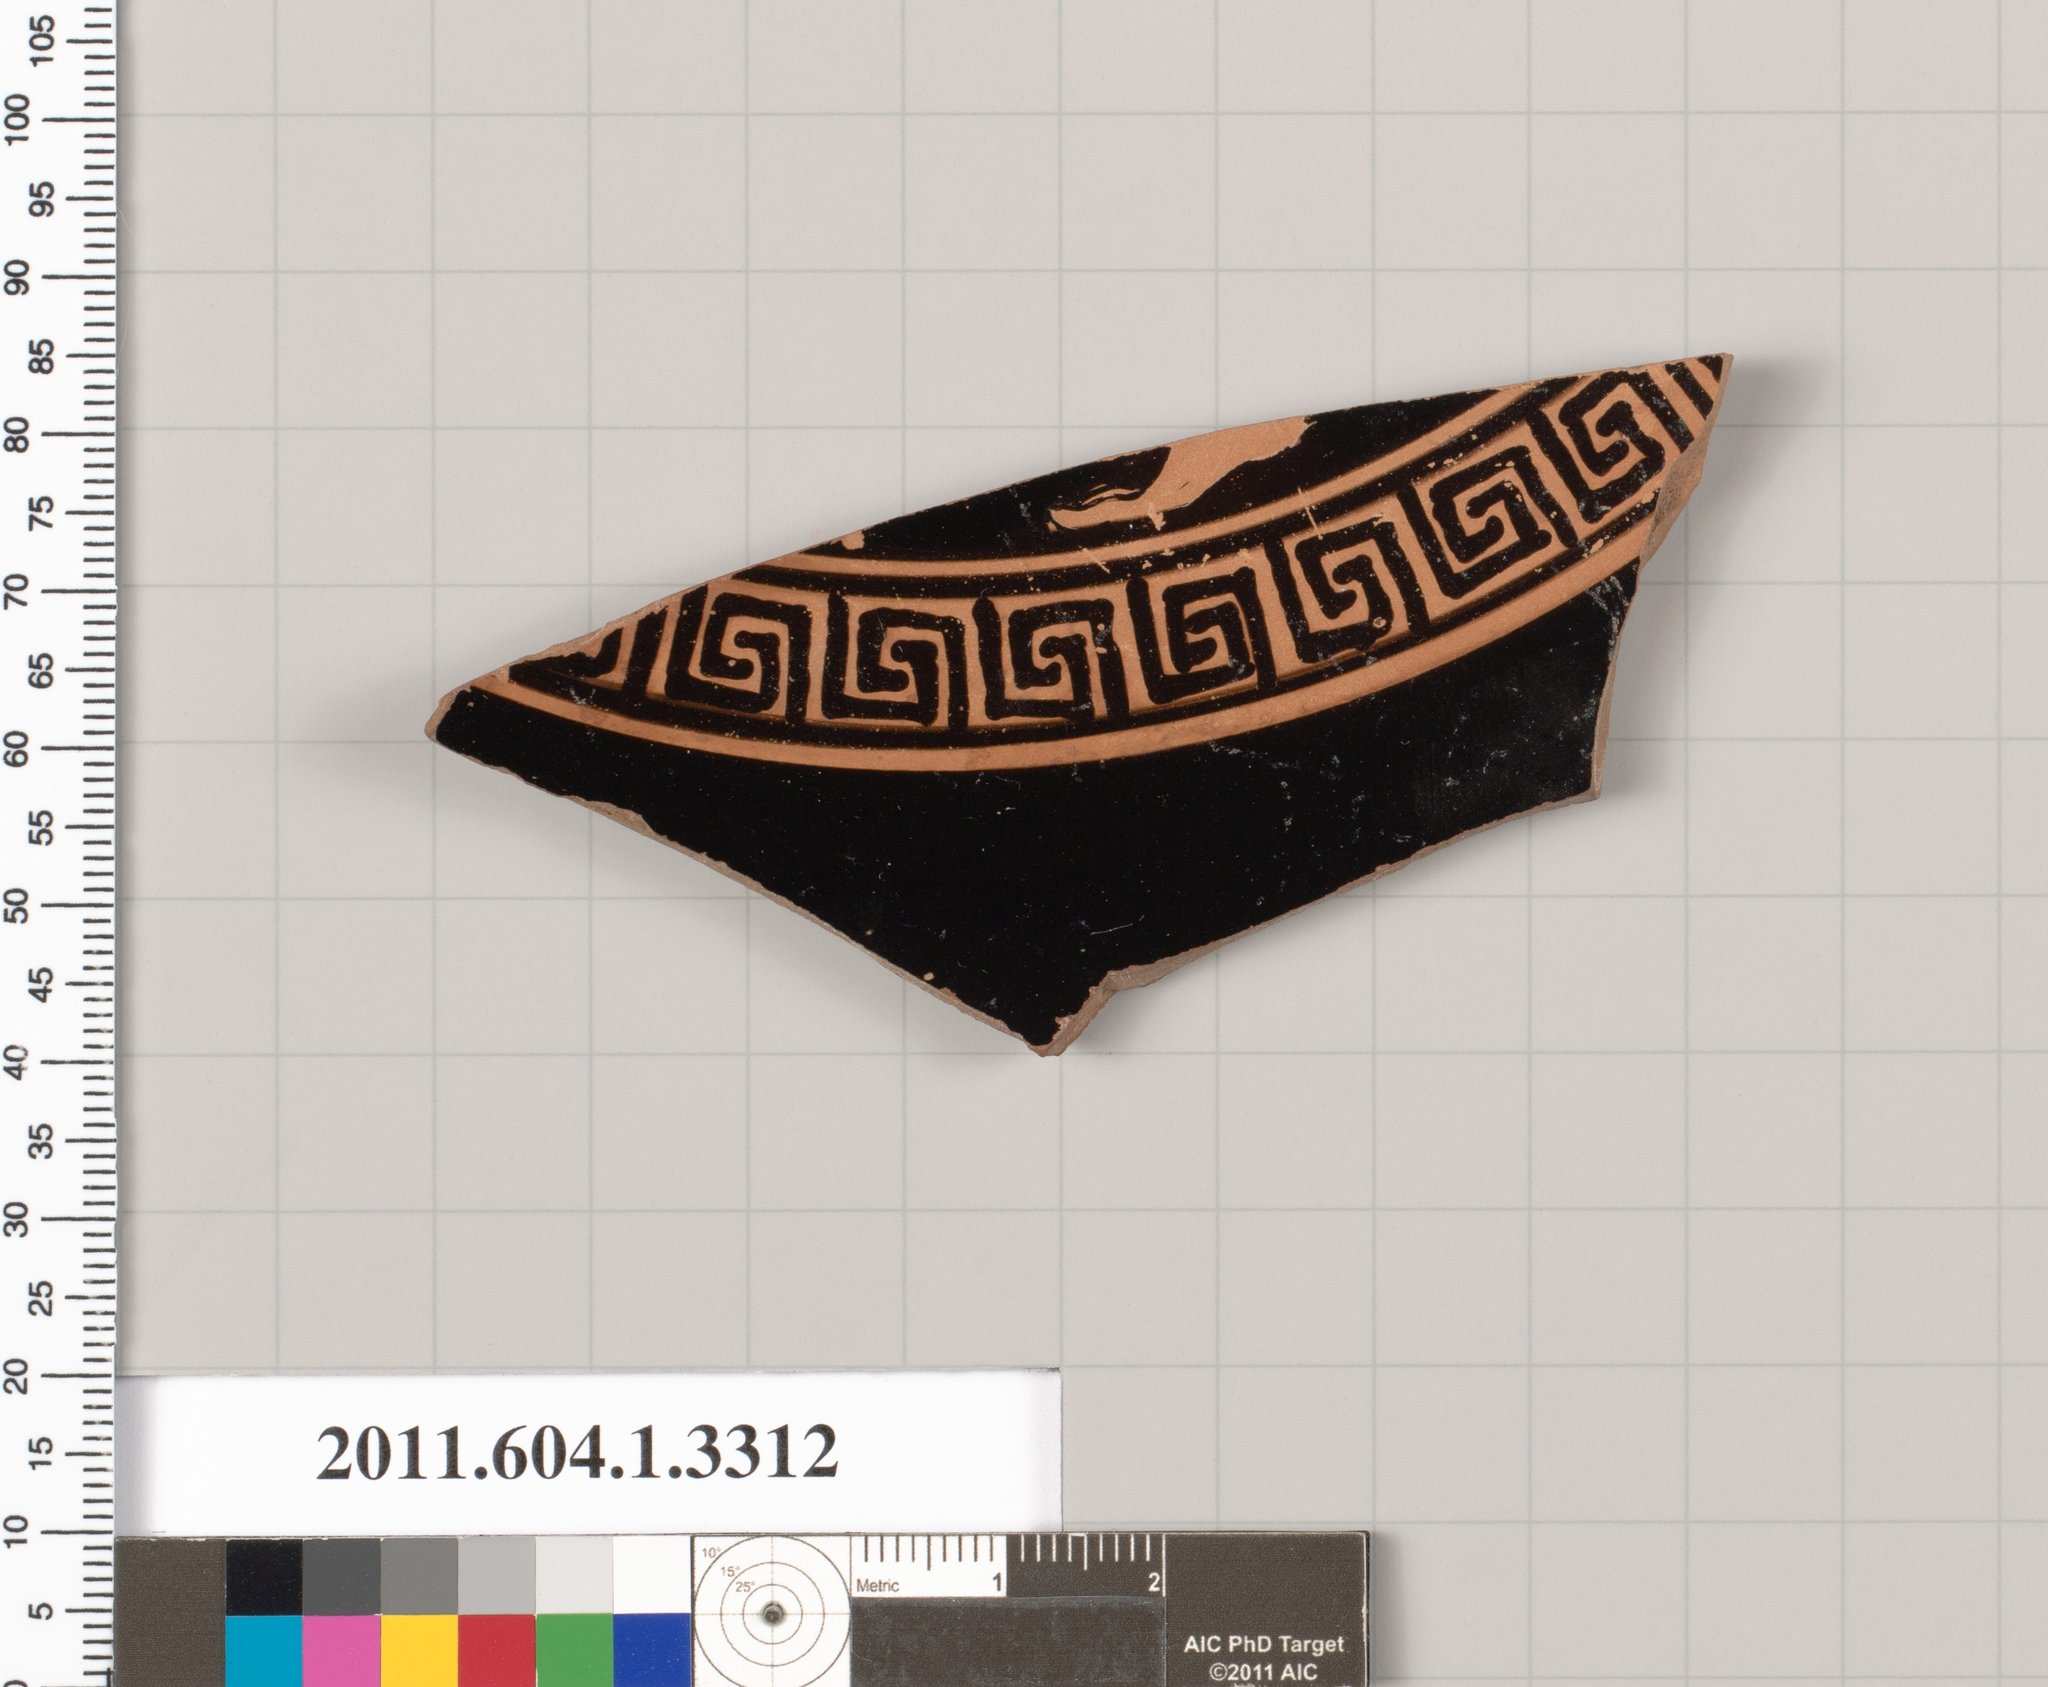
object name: kylix fragment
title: Terracotta fragment of a kylix (drinking cup)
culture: greek, attic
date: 500-480 BCE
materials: terracotta